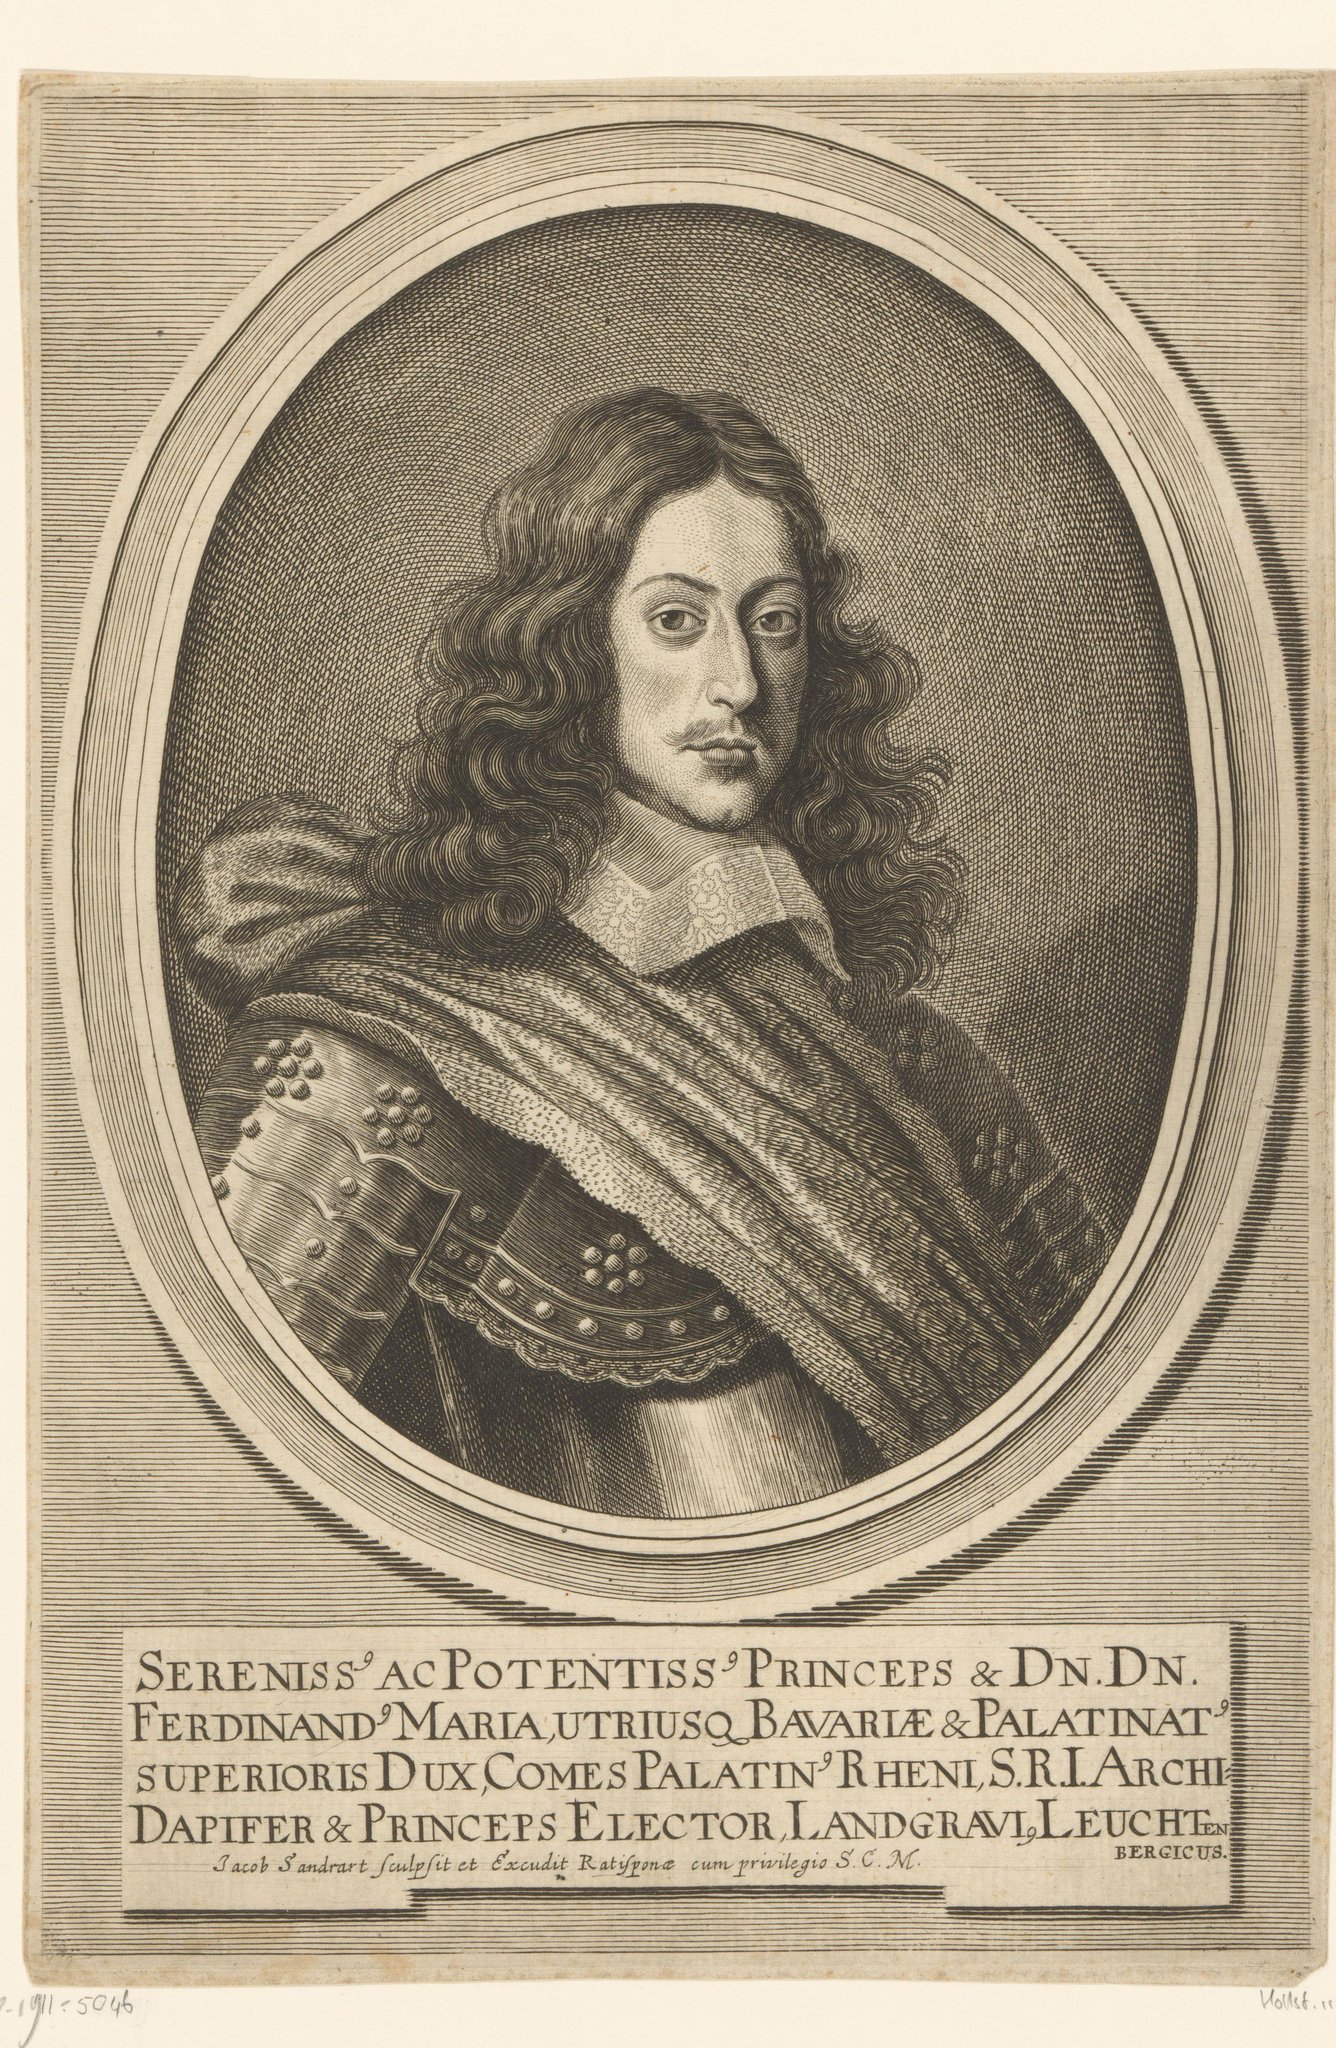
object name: print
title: Portret van Ferdinand Maria, keurvorst van Beieren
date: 1654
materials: paper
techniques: engraving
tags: ferdinand maria keurvorst van beieren, armour, historical persons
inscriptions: collector's mark: Lugt 2228